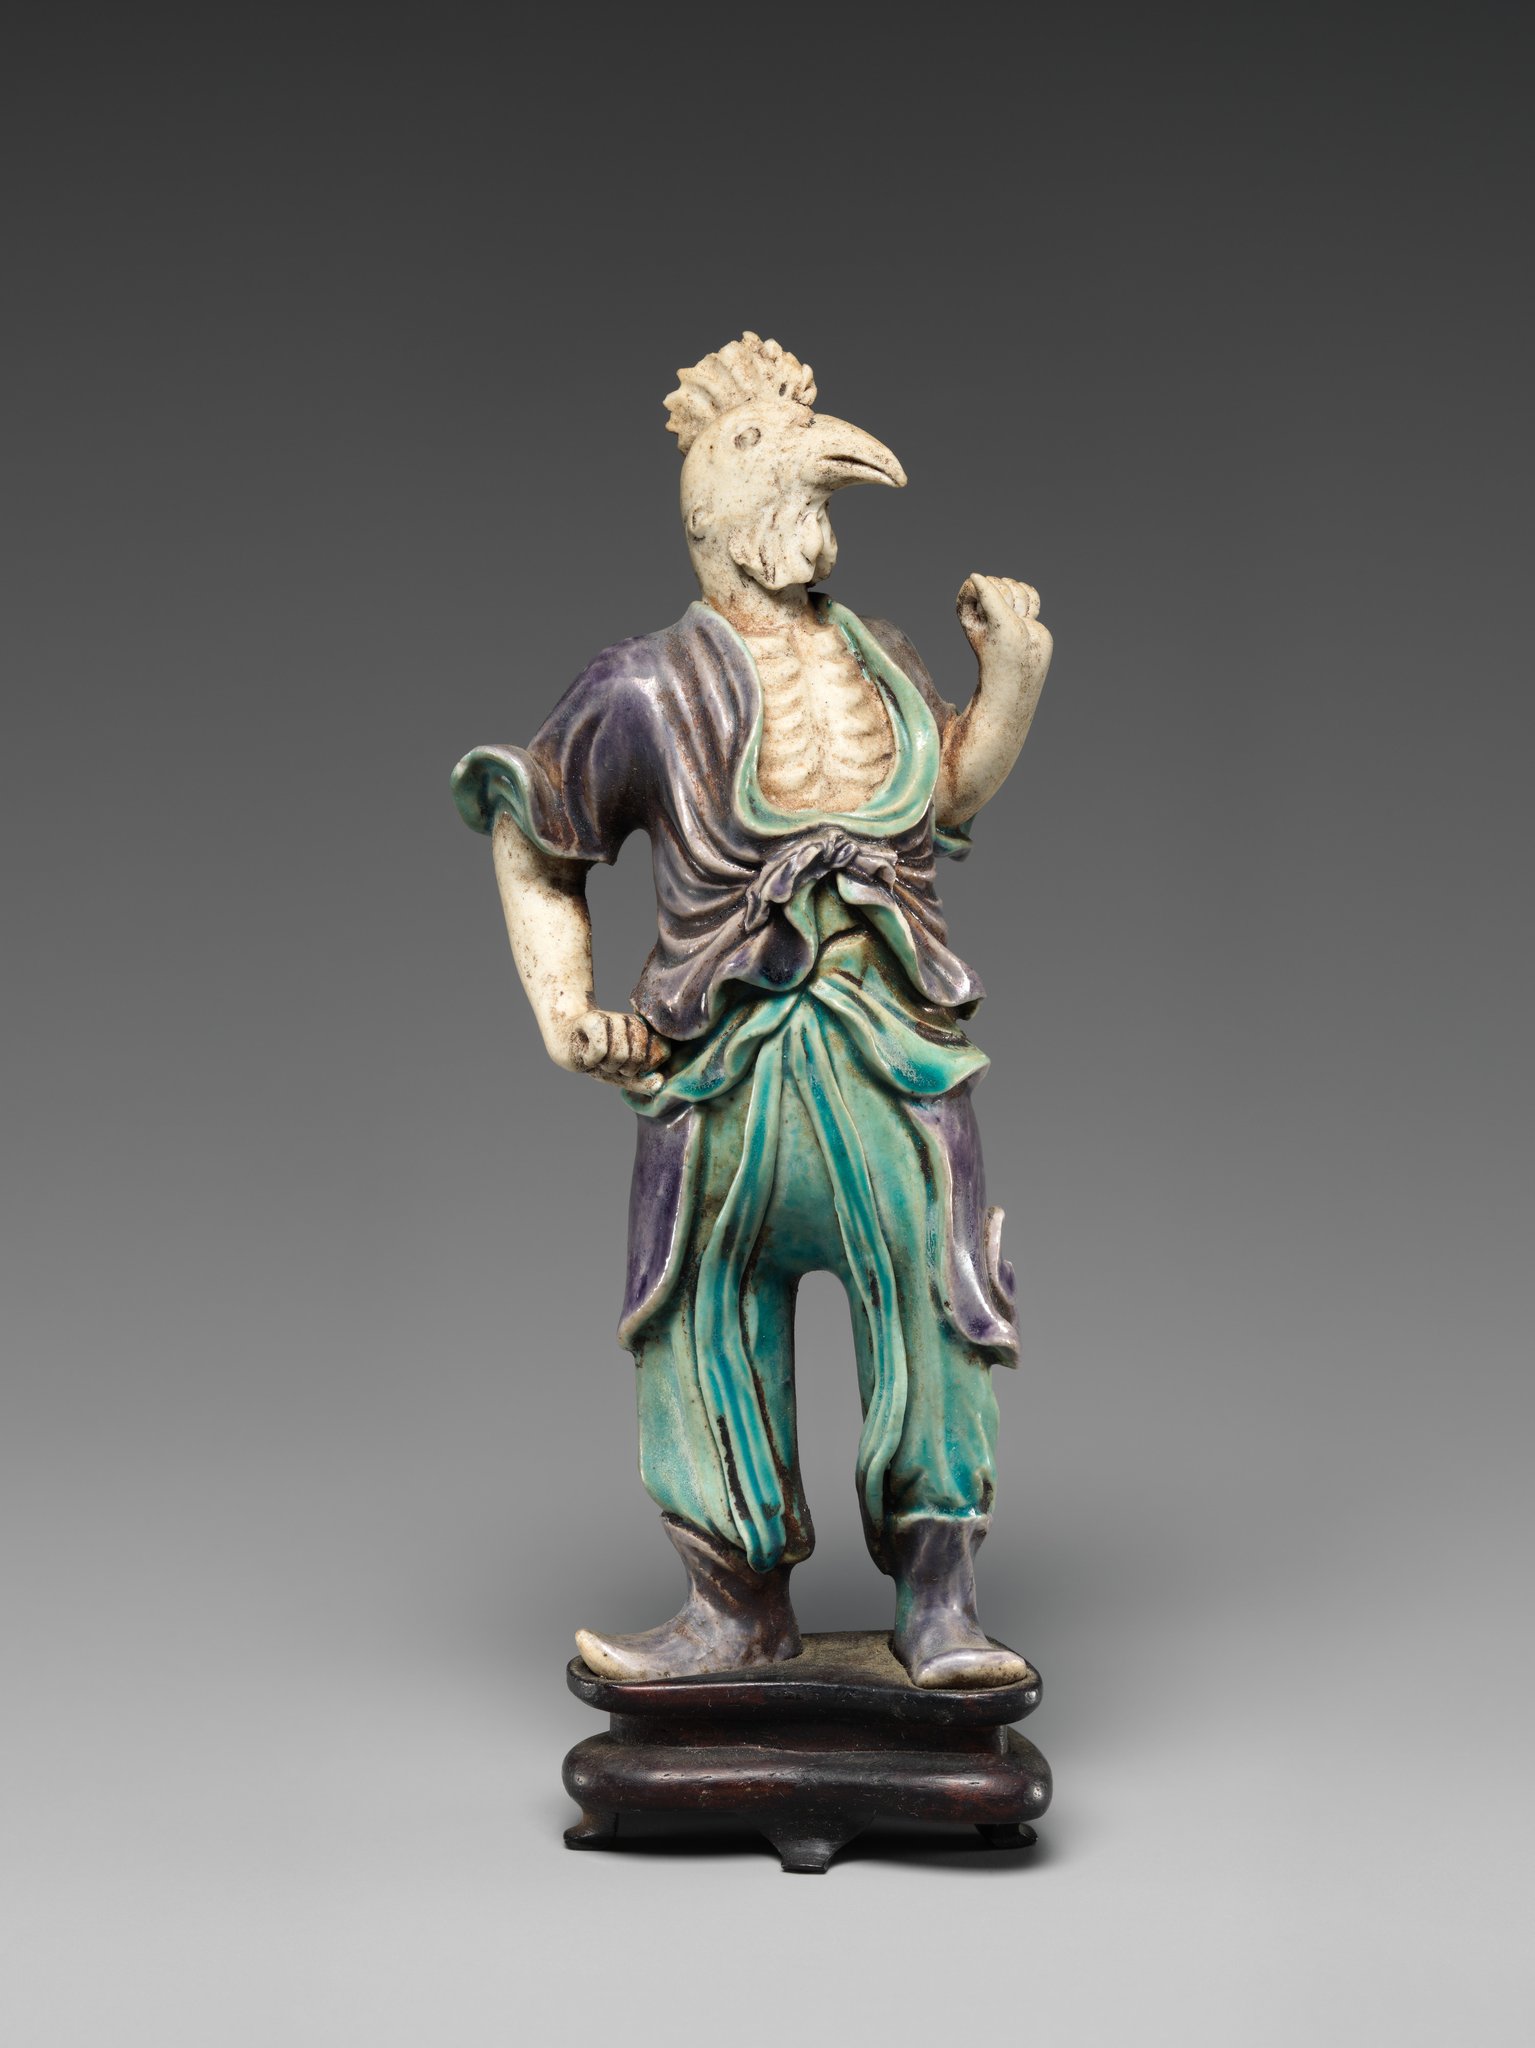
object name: figure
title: Zodiac Figure: Rooster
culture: chinese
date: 1701-1800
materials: biscuit, glaze, porcelain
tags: mythical creatures,roosters,zodiac